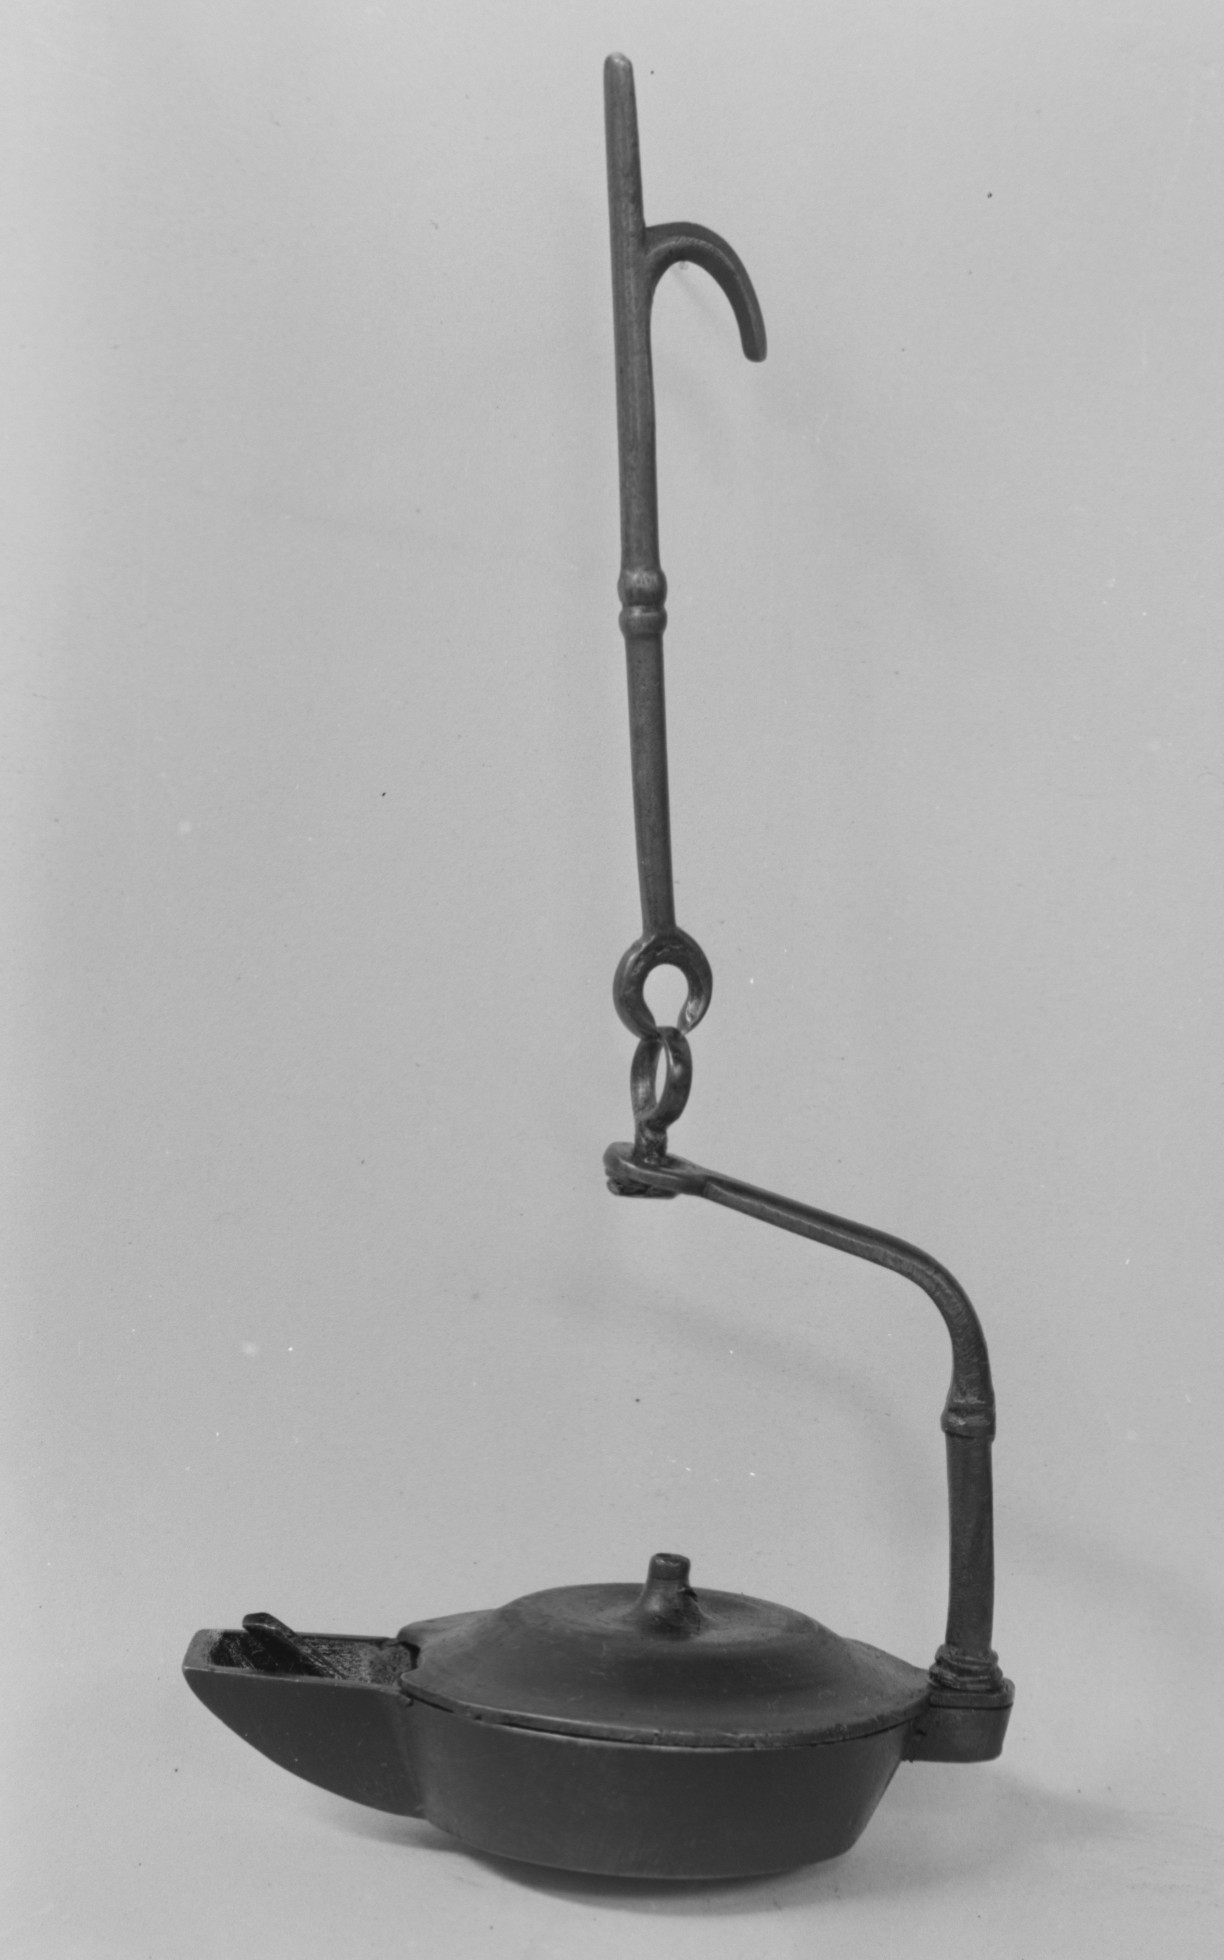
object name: betty lamp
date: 1701-1800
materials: iron